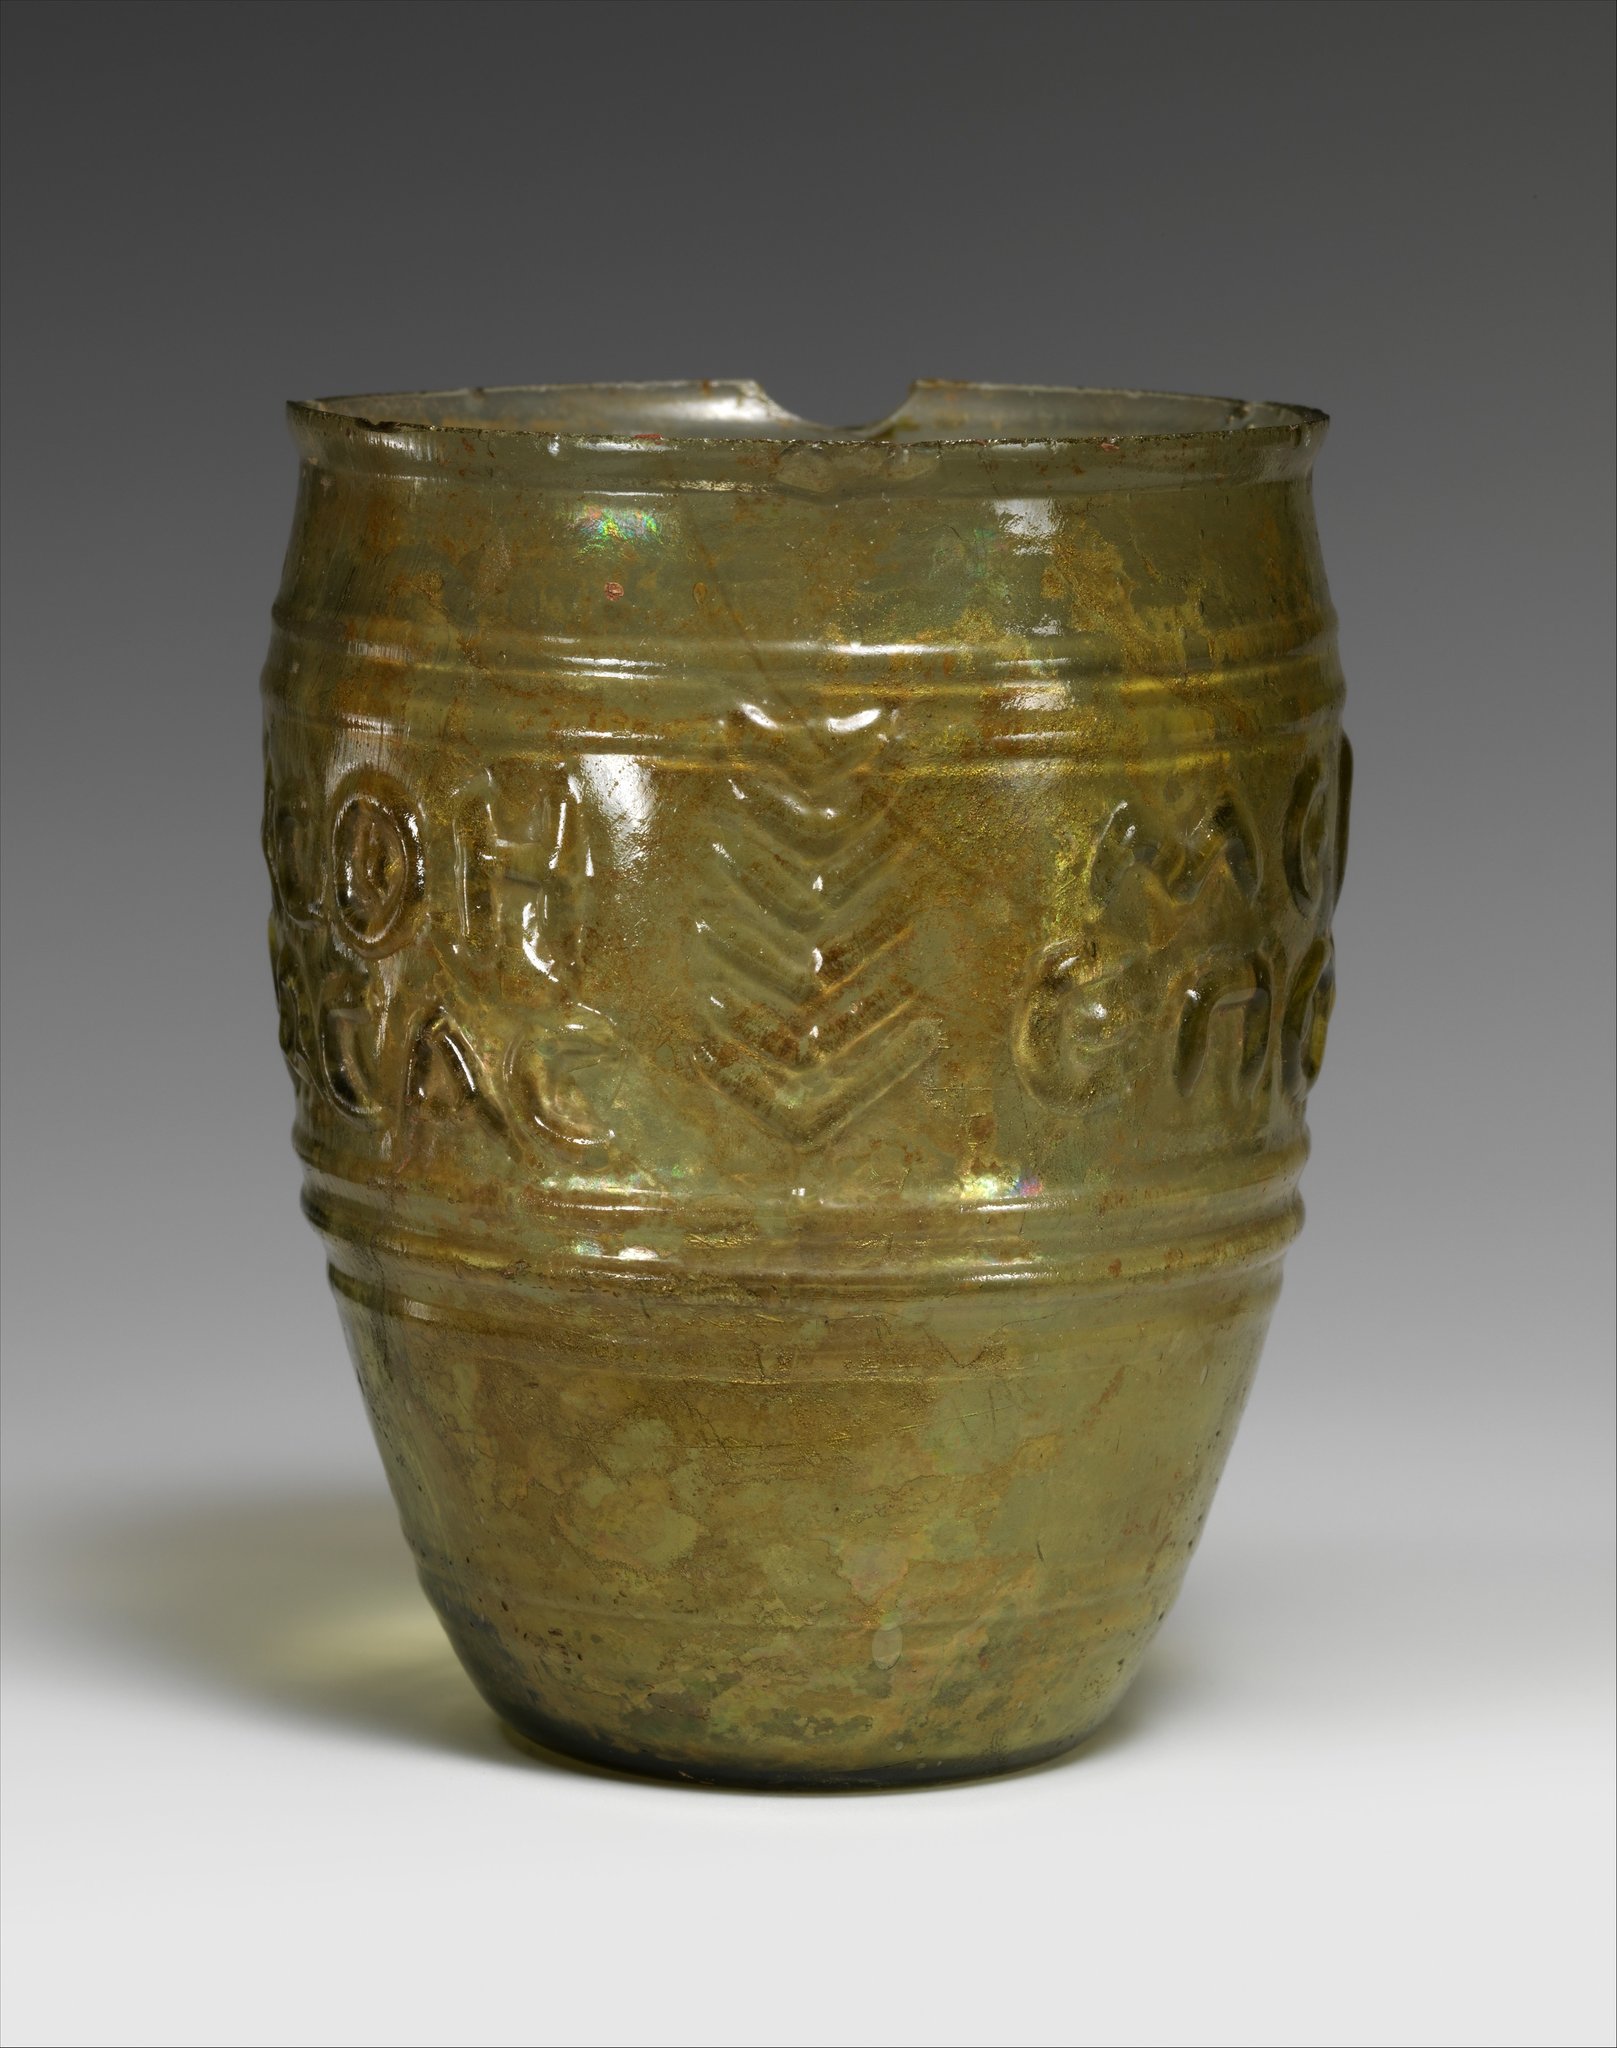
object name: beaker signed by meges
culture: roman, syro-palestinian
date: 34-66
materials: glass